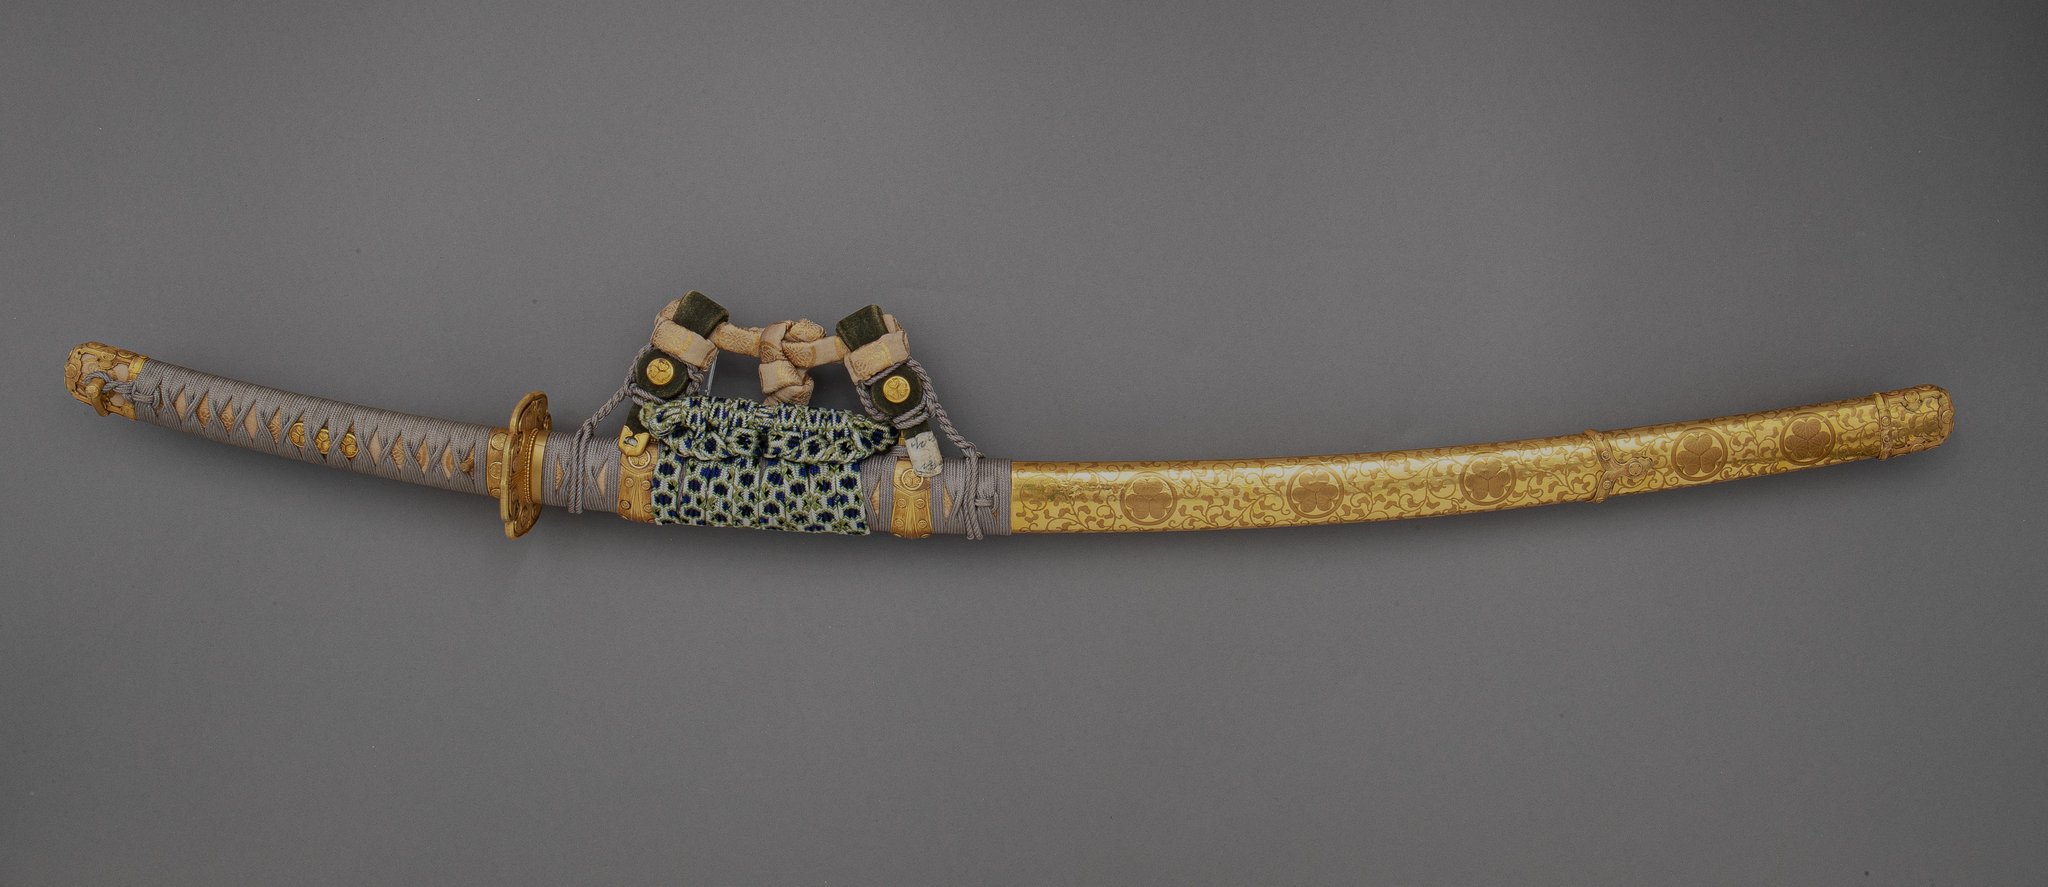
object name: mounting for a slung sword i itomaki tachi koshirae i with storage box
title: Mounting for a Slung Sword (Itomaki-tachi Koshirae) with Storage Box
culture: japanese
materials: gold, lacquer, leather, textile, wood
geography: japan